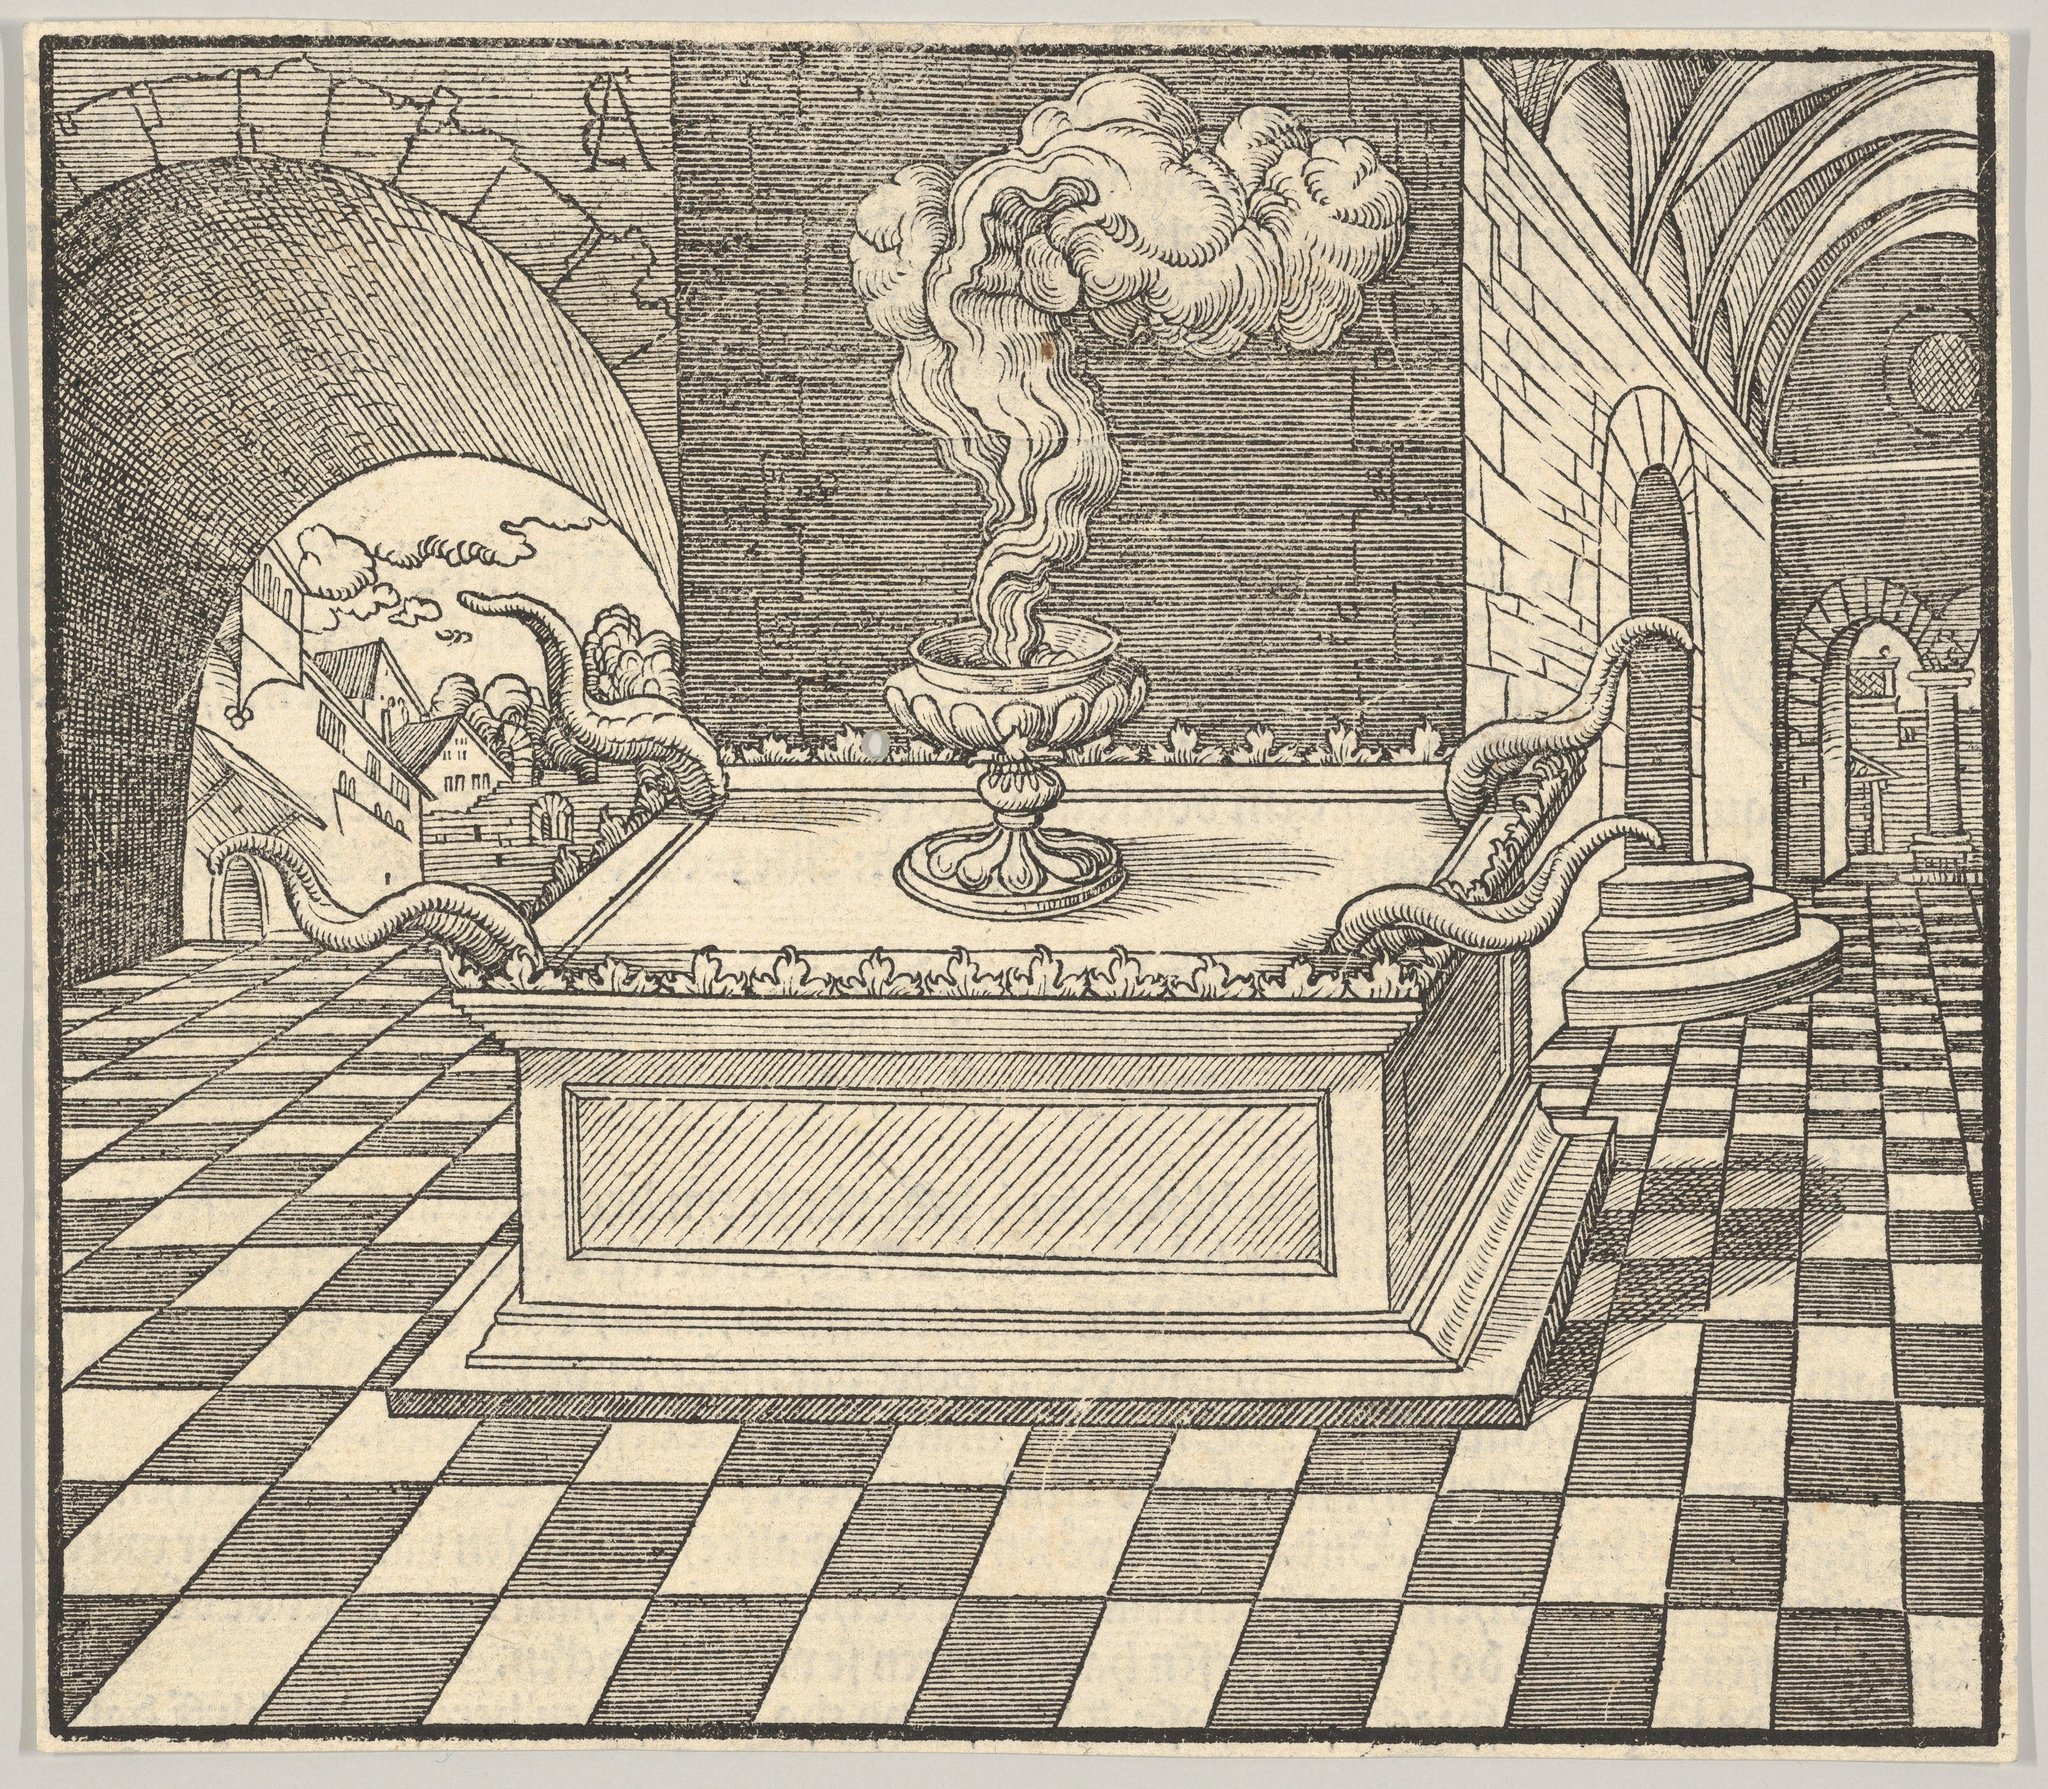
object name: print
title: The Altar of Incense, from "De Biblie uth der uthlegginge Doctoris Martini Luthers"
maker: erhard altdorfer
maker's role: artist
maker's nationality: german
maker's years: 1480-1562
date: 1530-1535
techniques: woodcut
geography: germany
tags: altars,incense burners